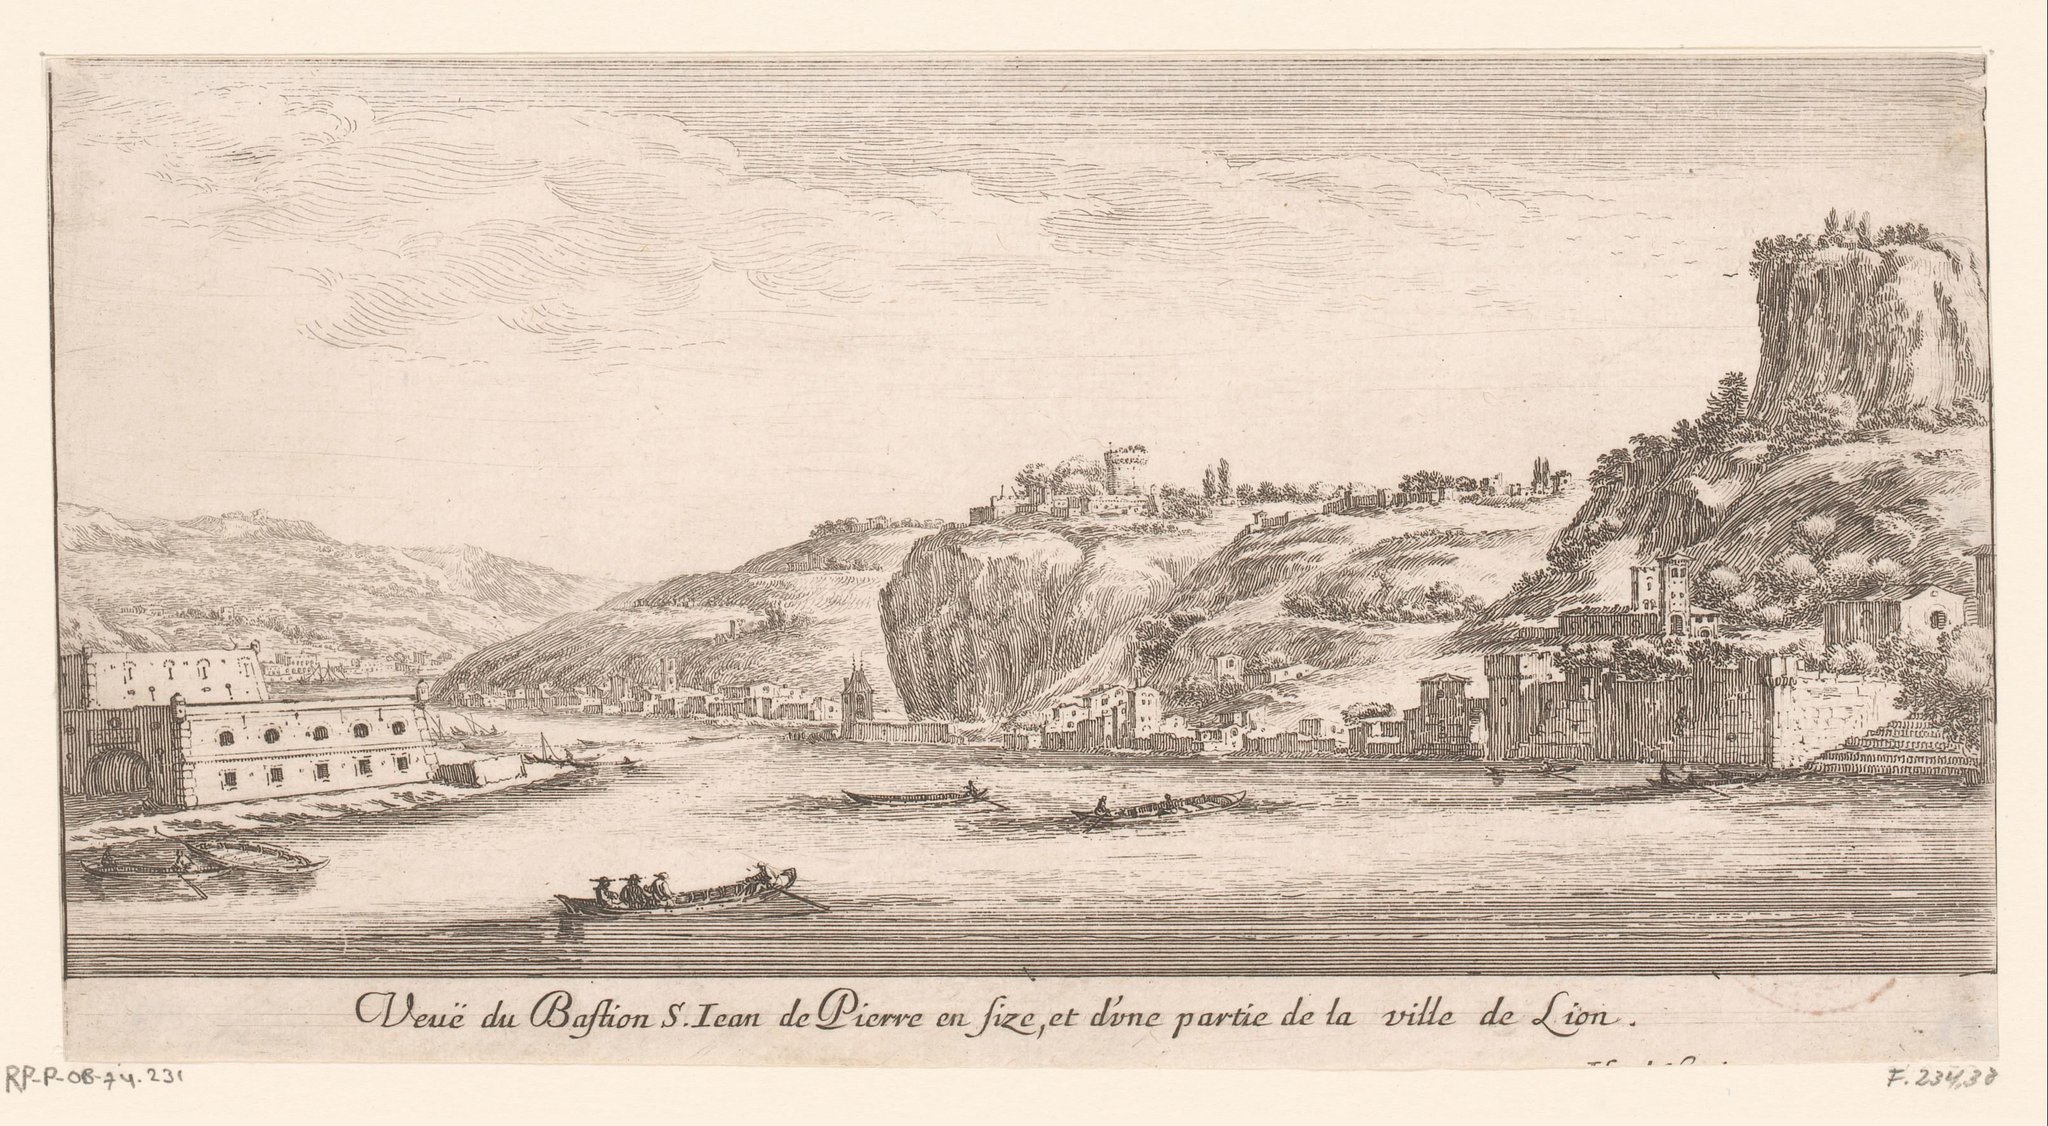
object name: print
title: Gezicht op het bastion van Sint Johannes in Pierre Scize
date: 1631-1691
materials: paper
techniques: engraving, etching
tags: city-view, and landscape with man-made constructions, lyon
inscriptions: collector's mark: Lugt 240